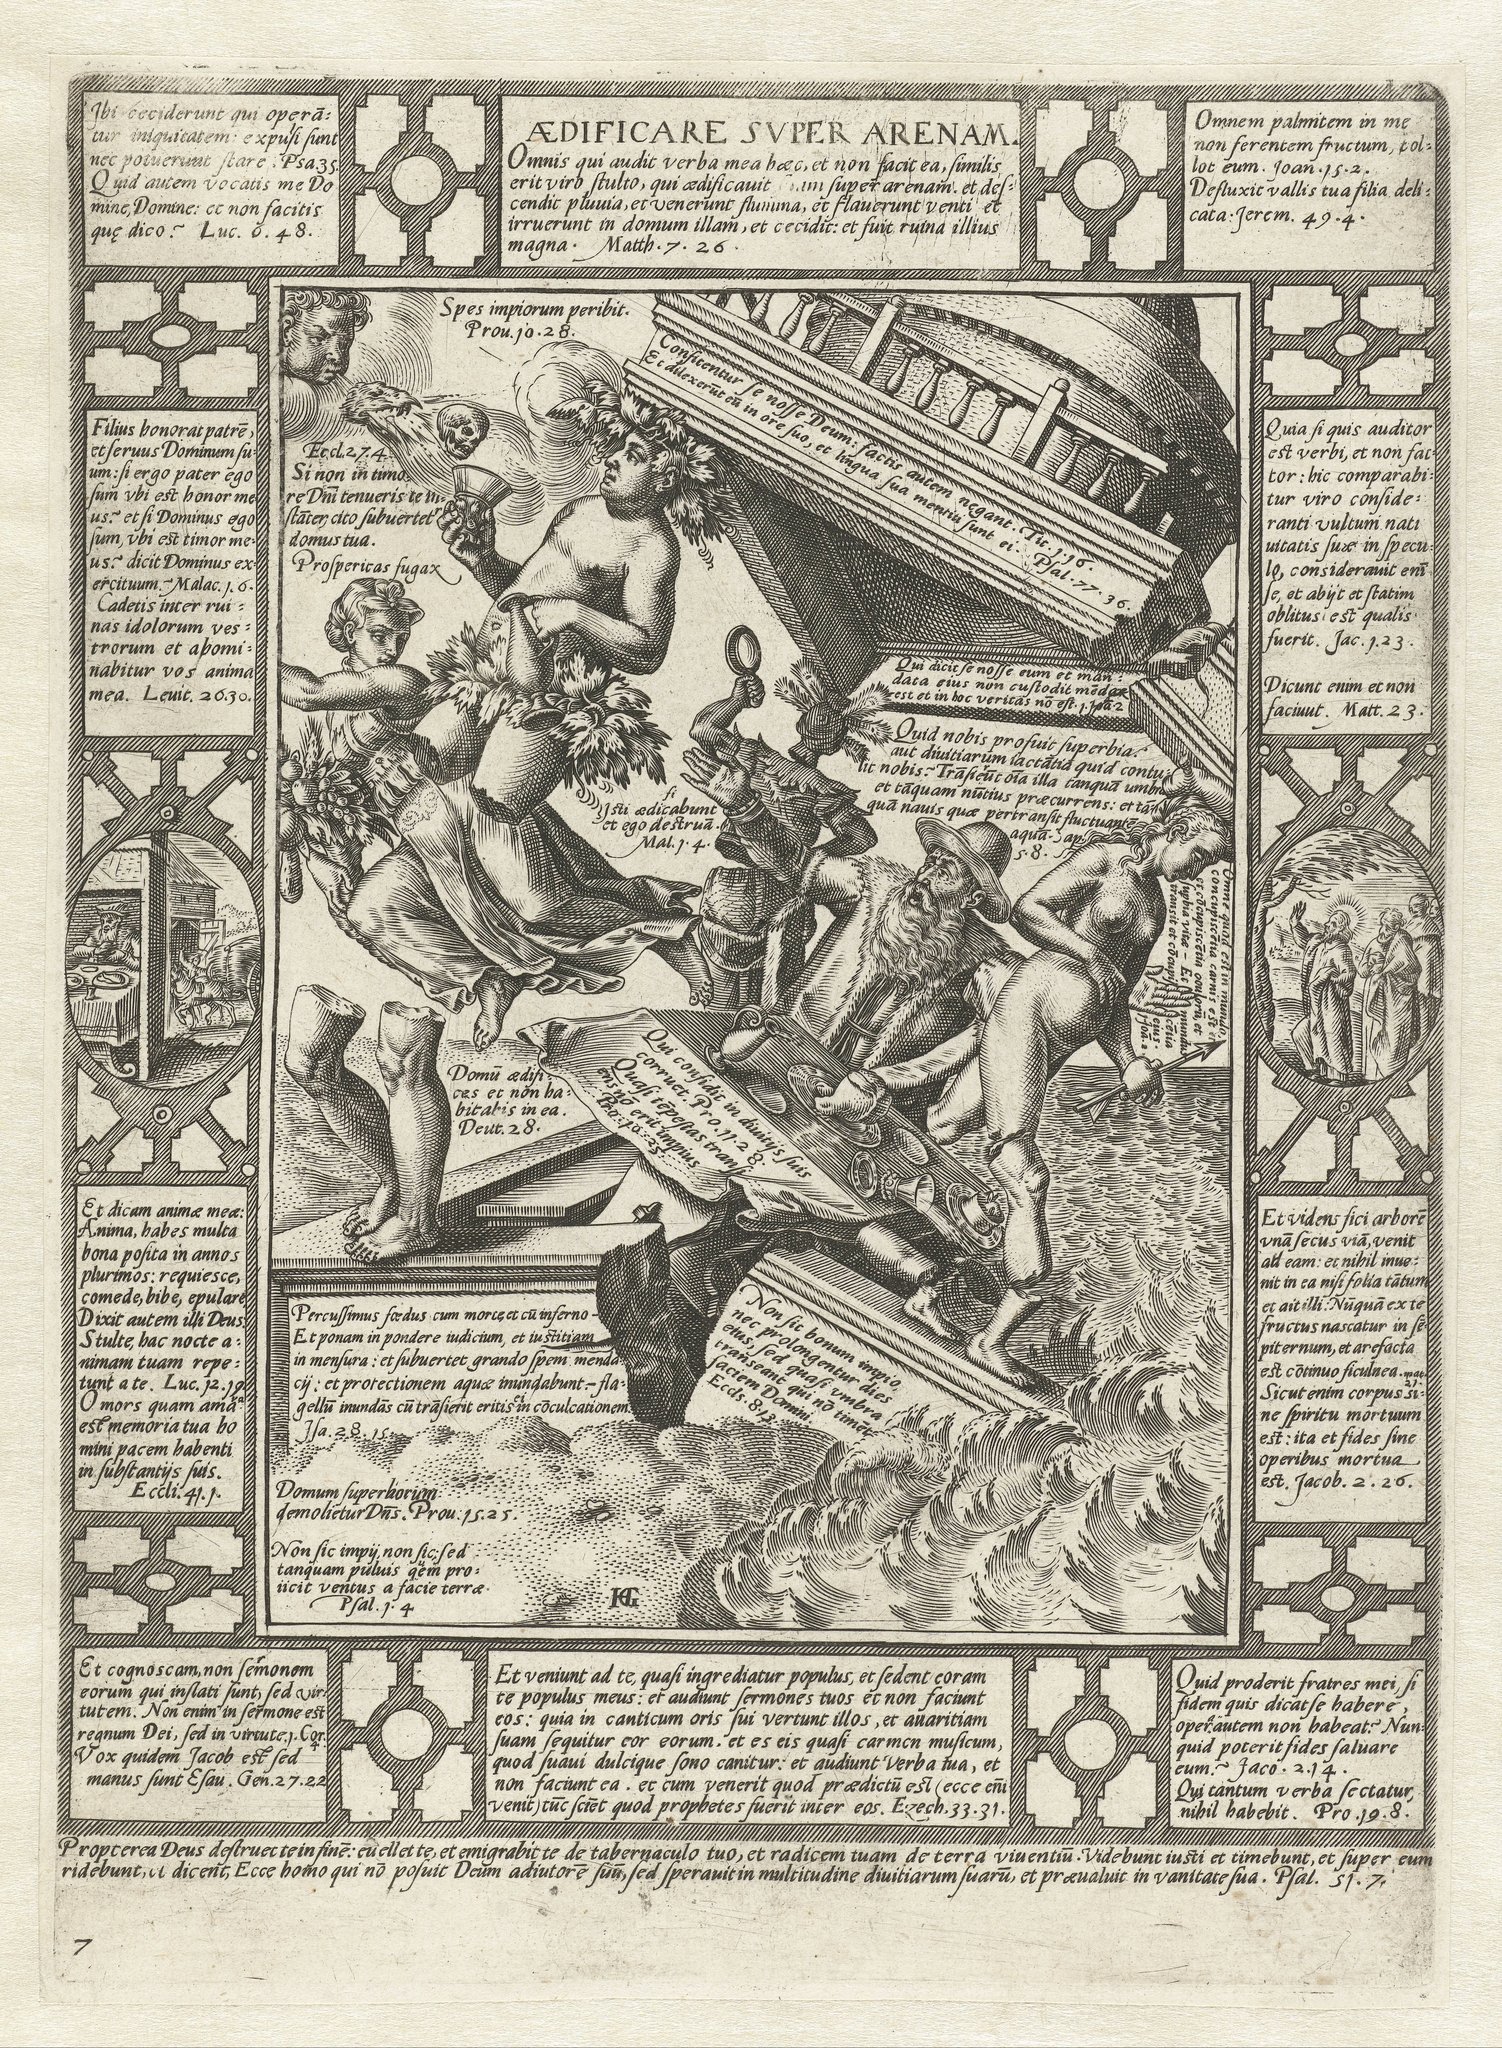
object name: print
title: Allegorieën van het christelijke geloof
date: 1598-1604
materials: paper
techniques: engraving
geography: haarlem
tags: house built upon a rock; house built upon sand ~ doctrine of christ on love, etc. (matthew 7:24-27; luke 6:47-49)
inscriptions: collector's mark: Lugt 240, monogram: ‘HG’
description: Serie van tien (oorspronkelijk twaalf) allegorieën van het christelijke geloof. Elk van de allegorieën bestaat uit een centrale voorstelling met daaromheen een omlijsting waarin citaten uit de bijbel gecombineerd zijn met de verbeelding van bepaalde gebeurtenissen uit de bijbel. In de marge onderaan twee regels Latijn en het nummer 7.